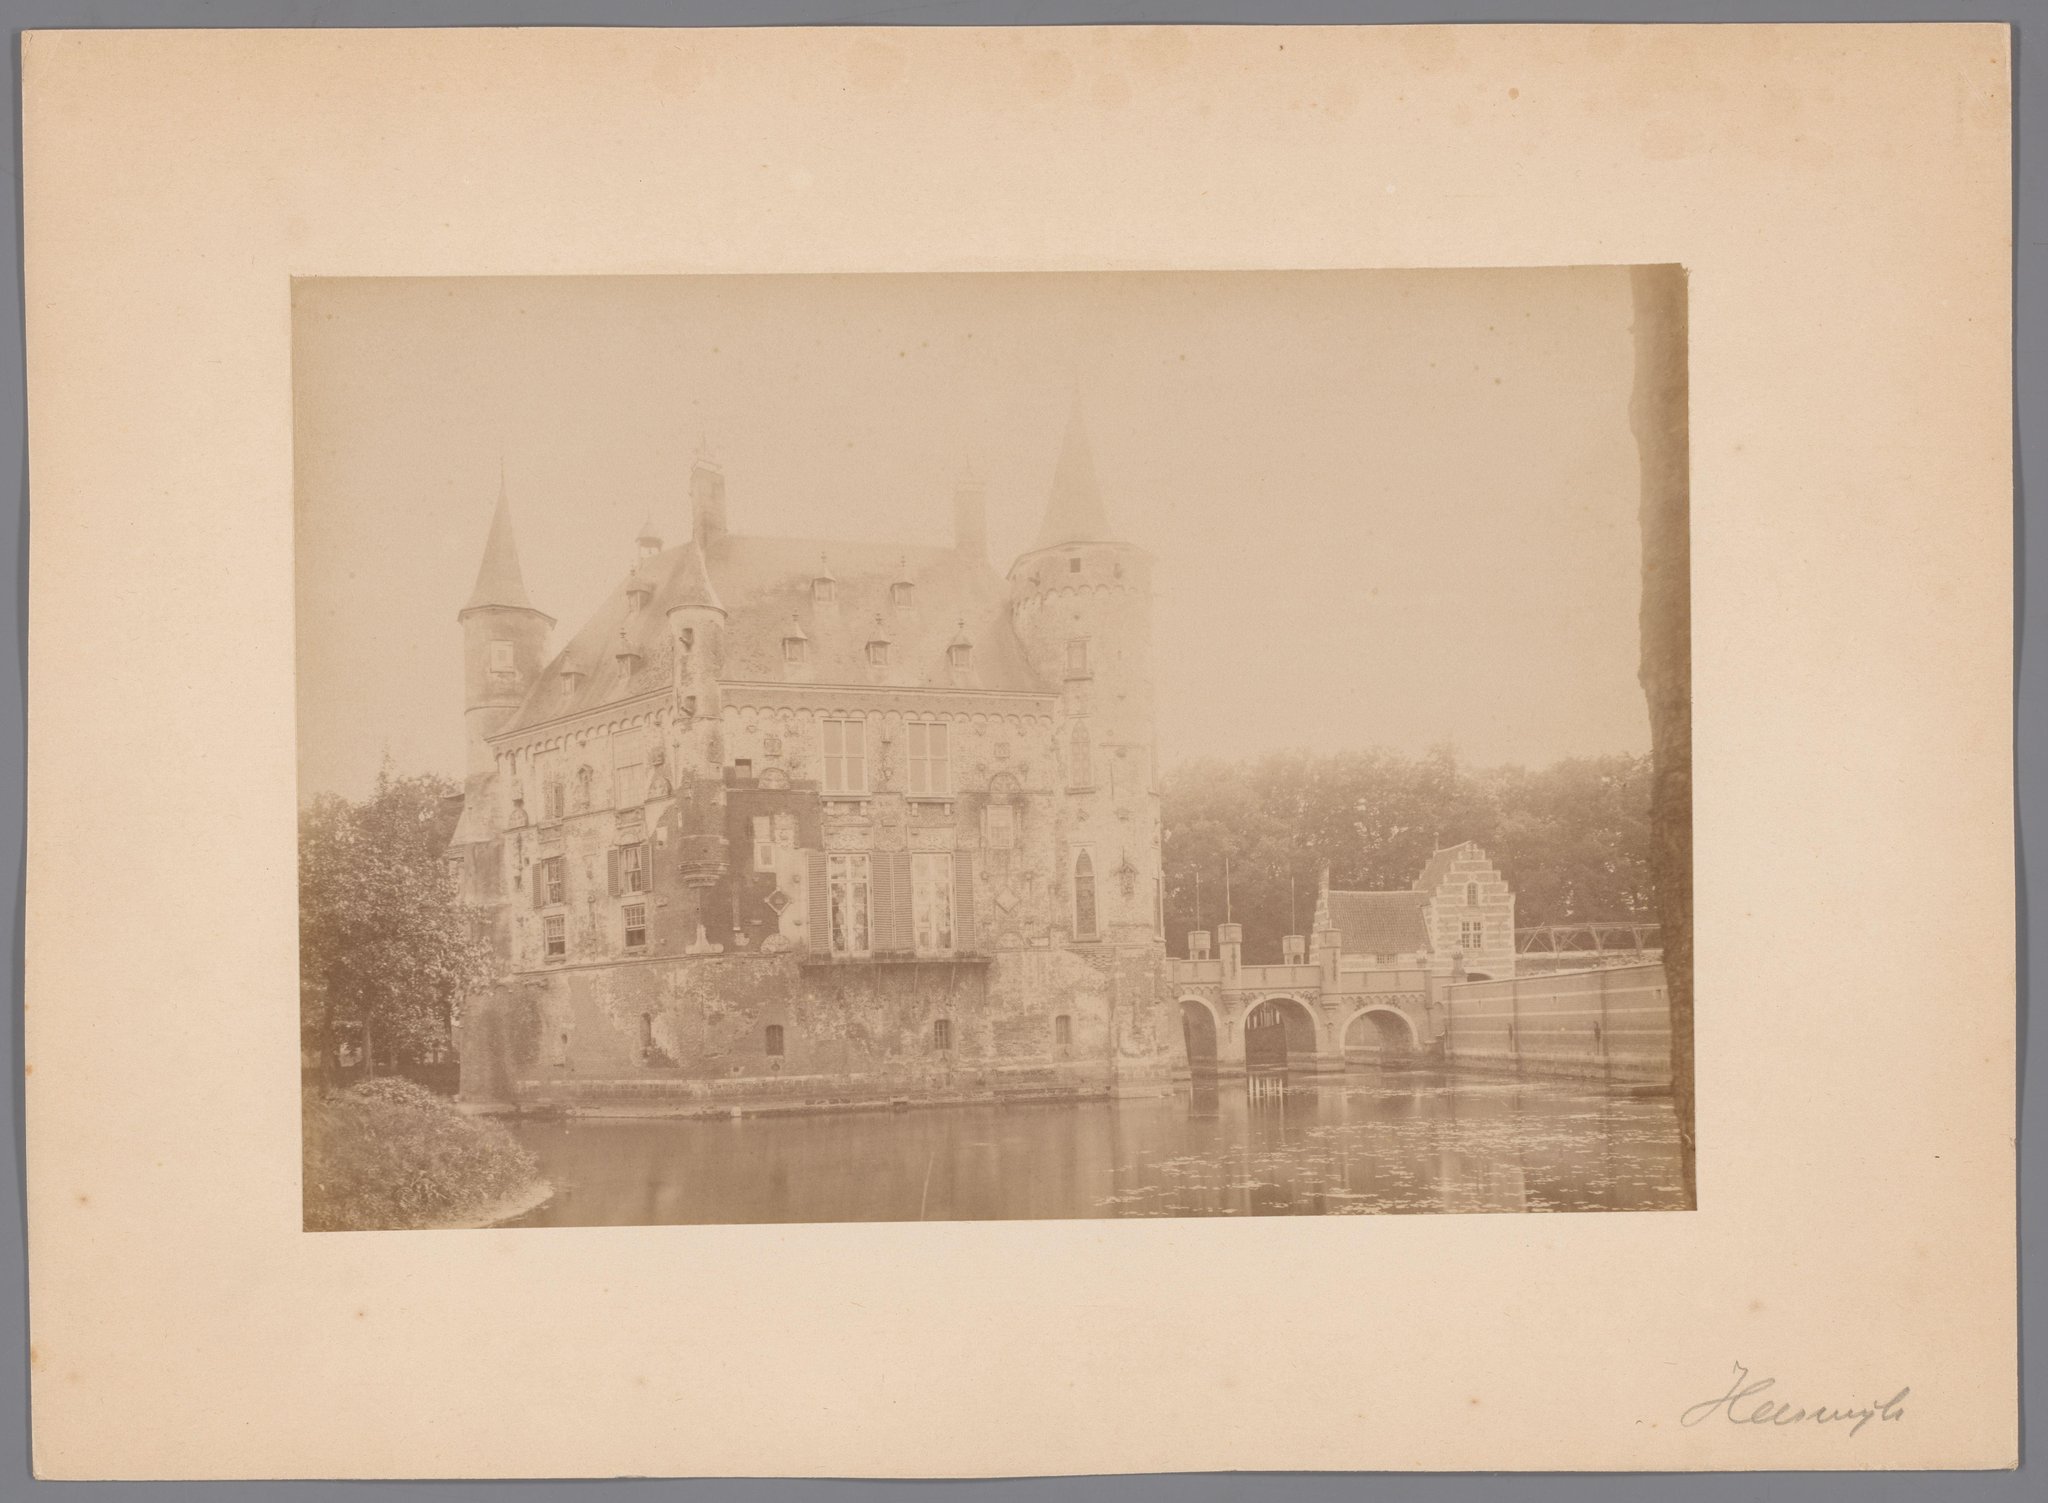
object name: photograph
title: Gezicht op Kasteel Heeswijk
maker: anoniem (monumentenzorg)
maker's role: fotograaf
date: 1892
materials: cardboard, photographic support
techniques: albumen print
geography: kasteel heeswijk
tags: landscape with tower or castle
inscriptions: annotation: ‘Heeswijk’, annotation: ‘Kasteel te Heeswijk (N.B.)/ Aug 1892’